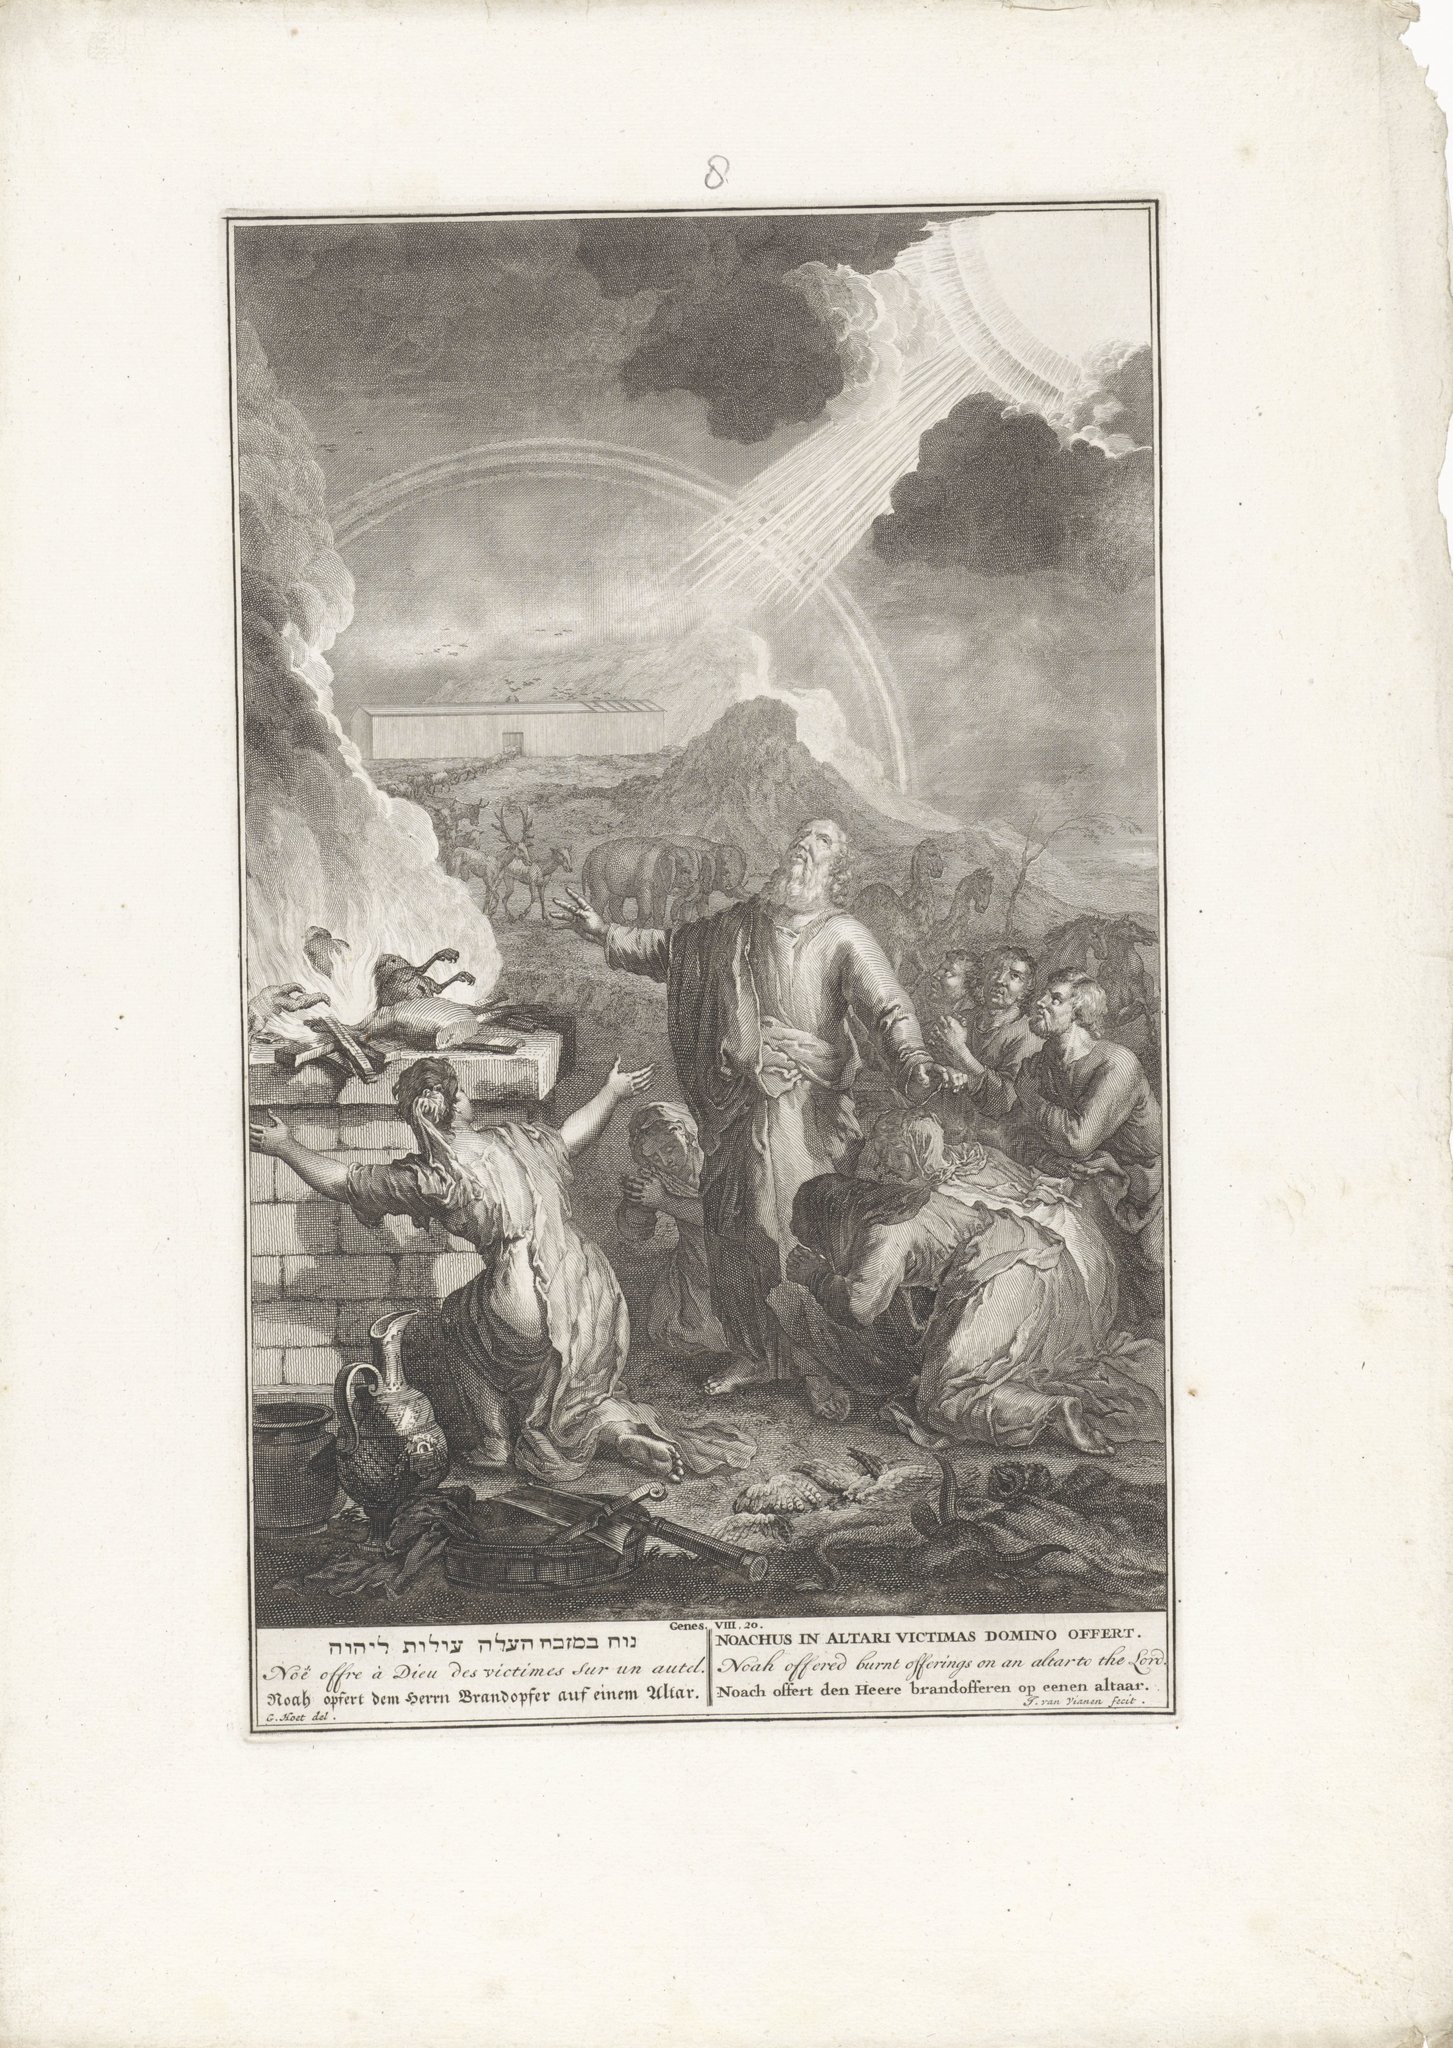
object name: print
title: Noach's offer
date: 1705-1720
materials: paper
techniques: engraving, etching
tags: noah's sacrifice; various animals are offered, possibly a lamb, a dove and a ram (often combined with the rainbow of the covenant)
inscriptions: collector's mark: Lugt 2228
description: Prent oorspronkelijk bedoeld voor: Figures de la Bible. Amsterdam: Bernard Picart, 1720. Prent ook gebruikt in: Taferelen der voornaamste geschiedenissen van het Oude en Nieuwe Testament (...) door de vermaarde kunstenaars Hoet, Houbraken, en Picart getekent (...) en met beschrijvingen uitgebreid. Den Haag: Pieter de Hondt, 1728.